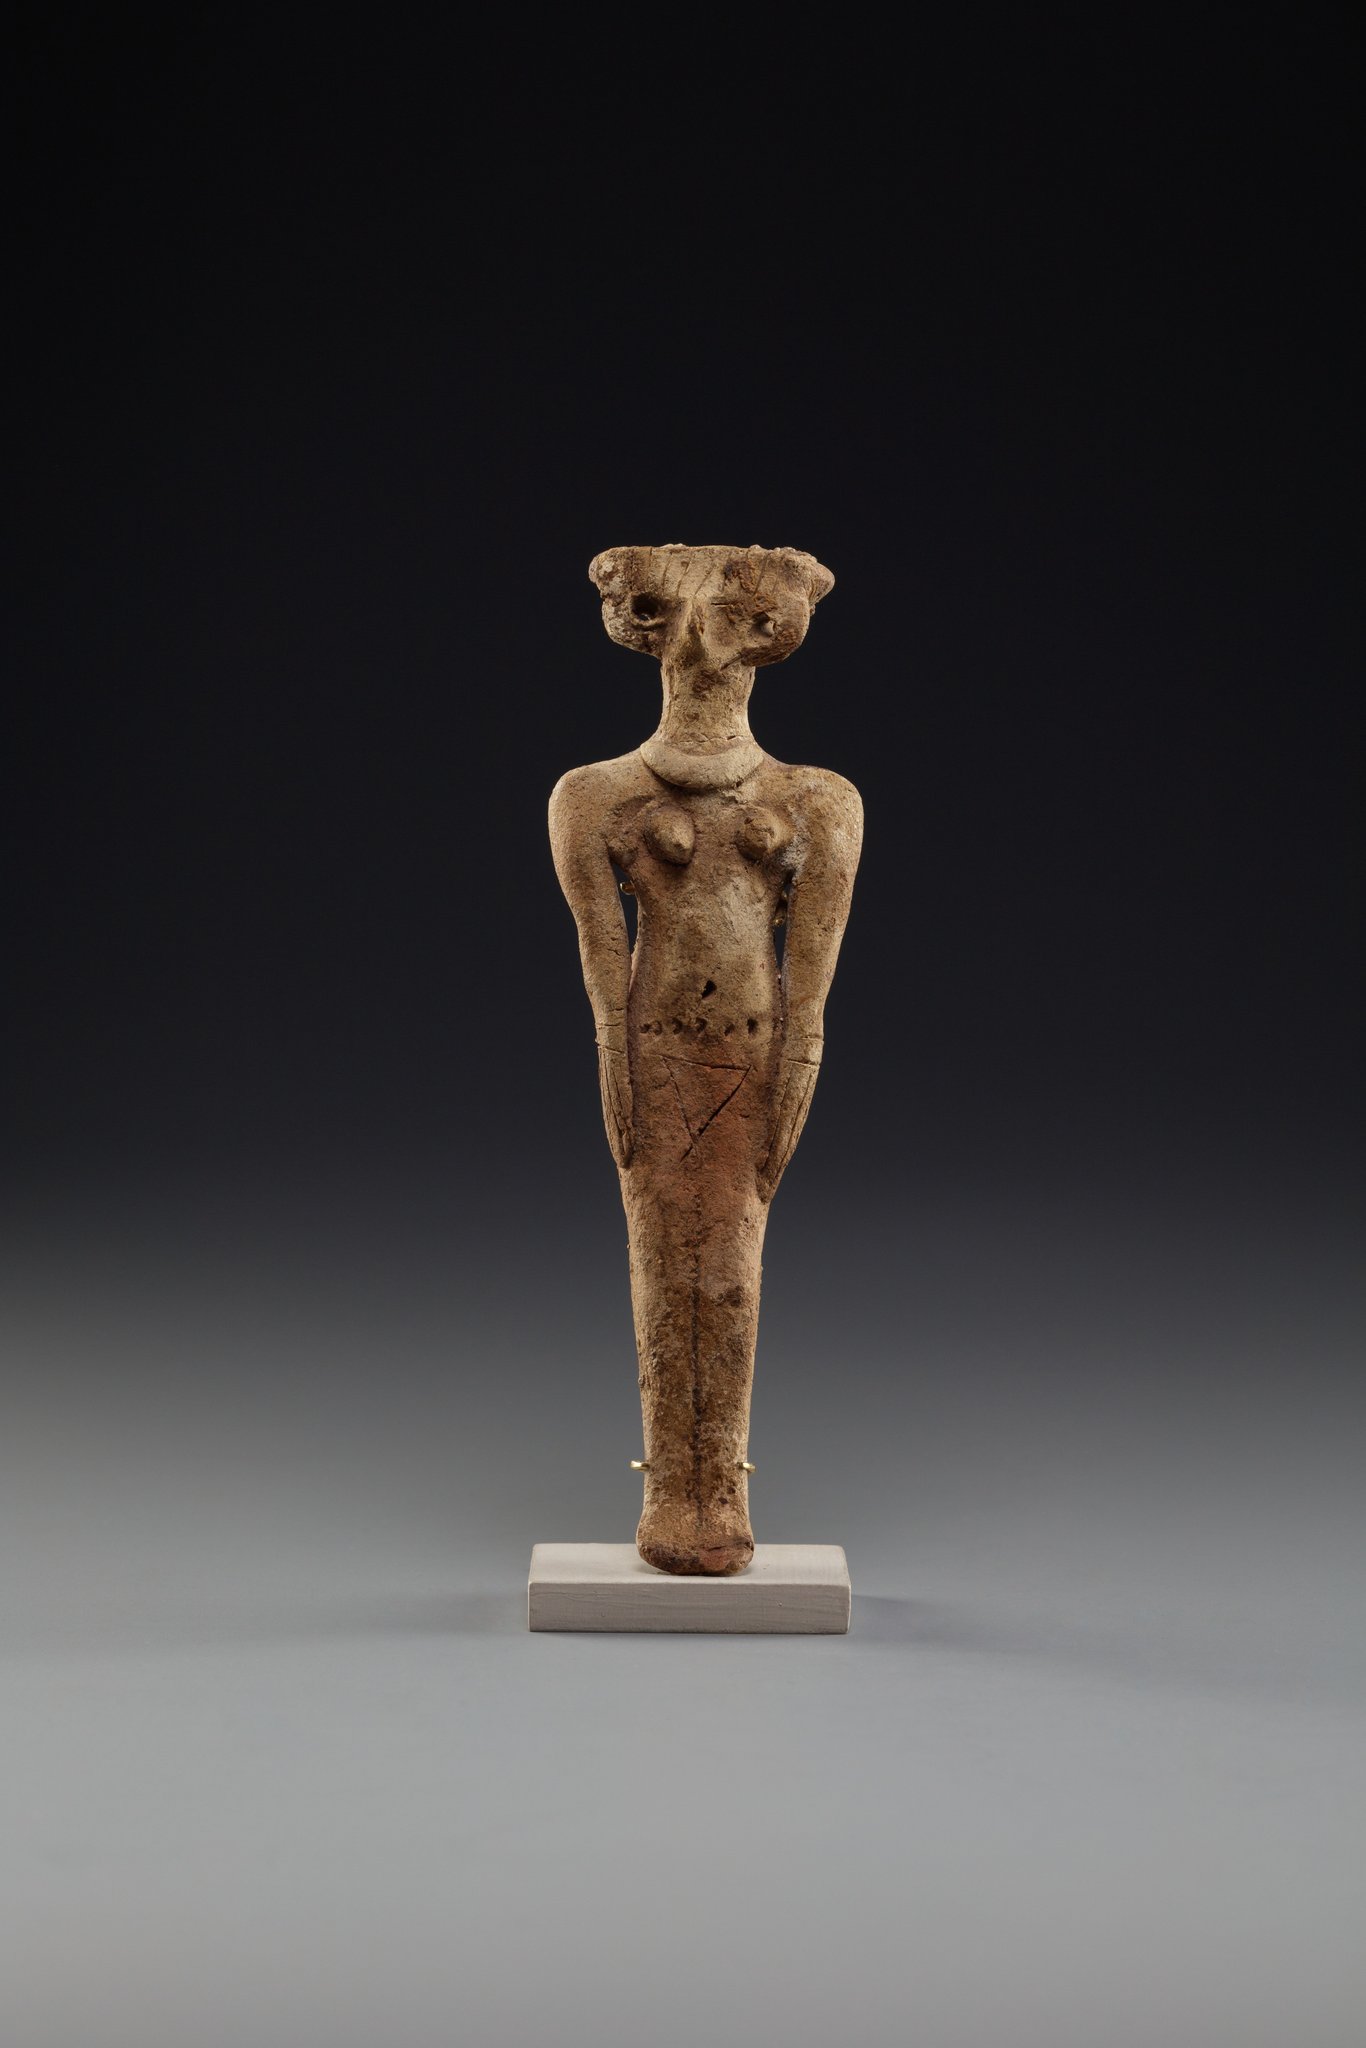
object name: female figure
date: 1981-1550 BCE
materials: clay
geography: egypt